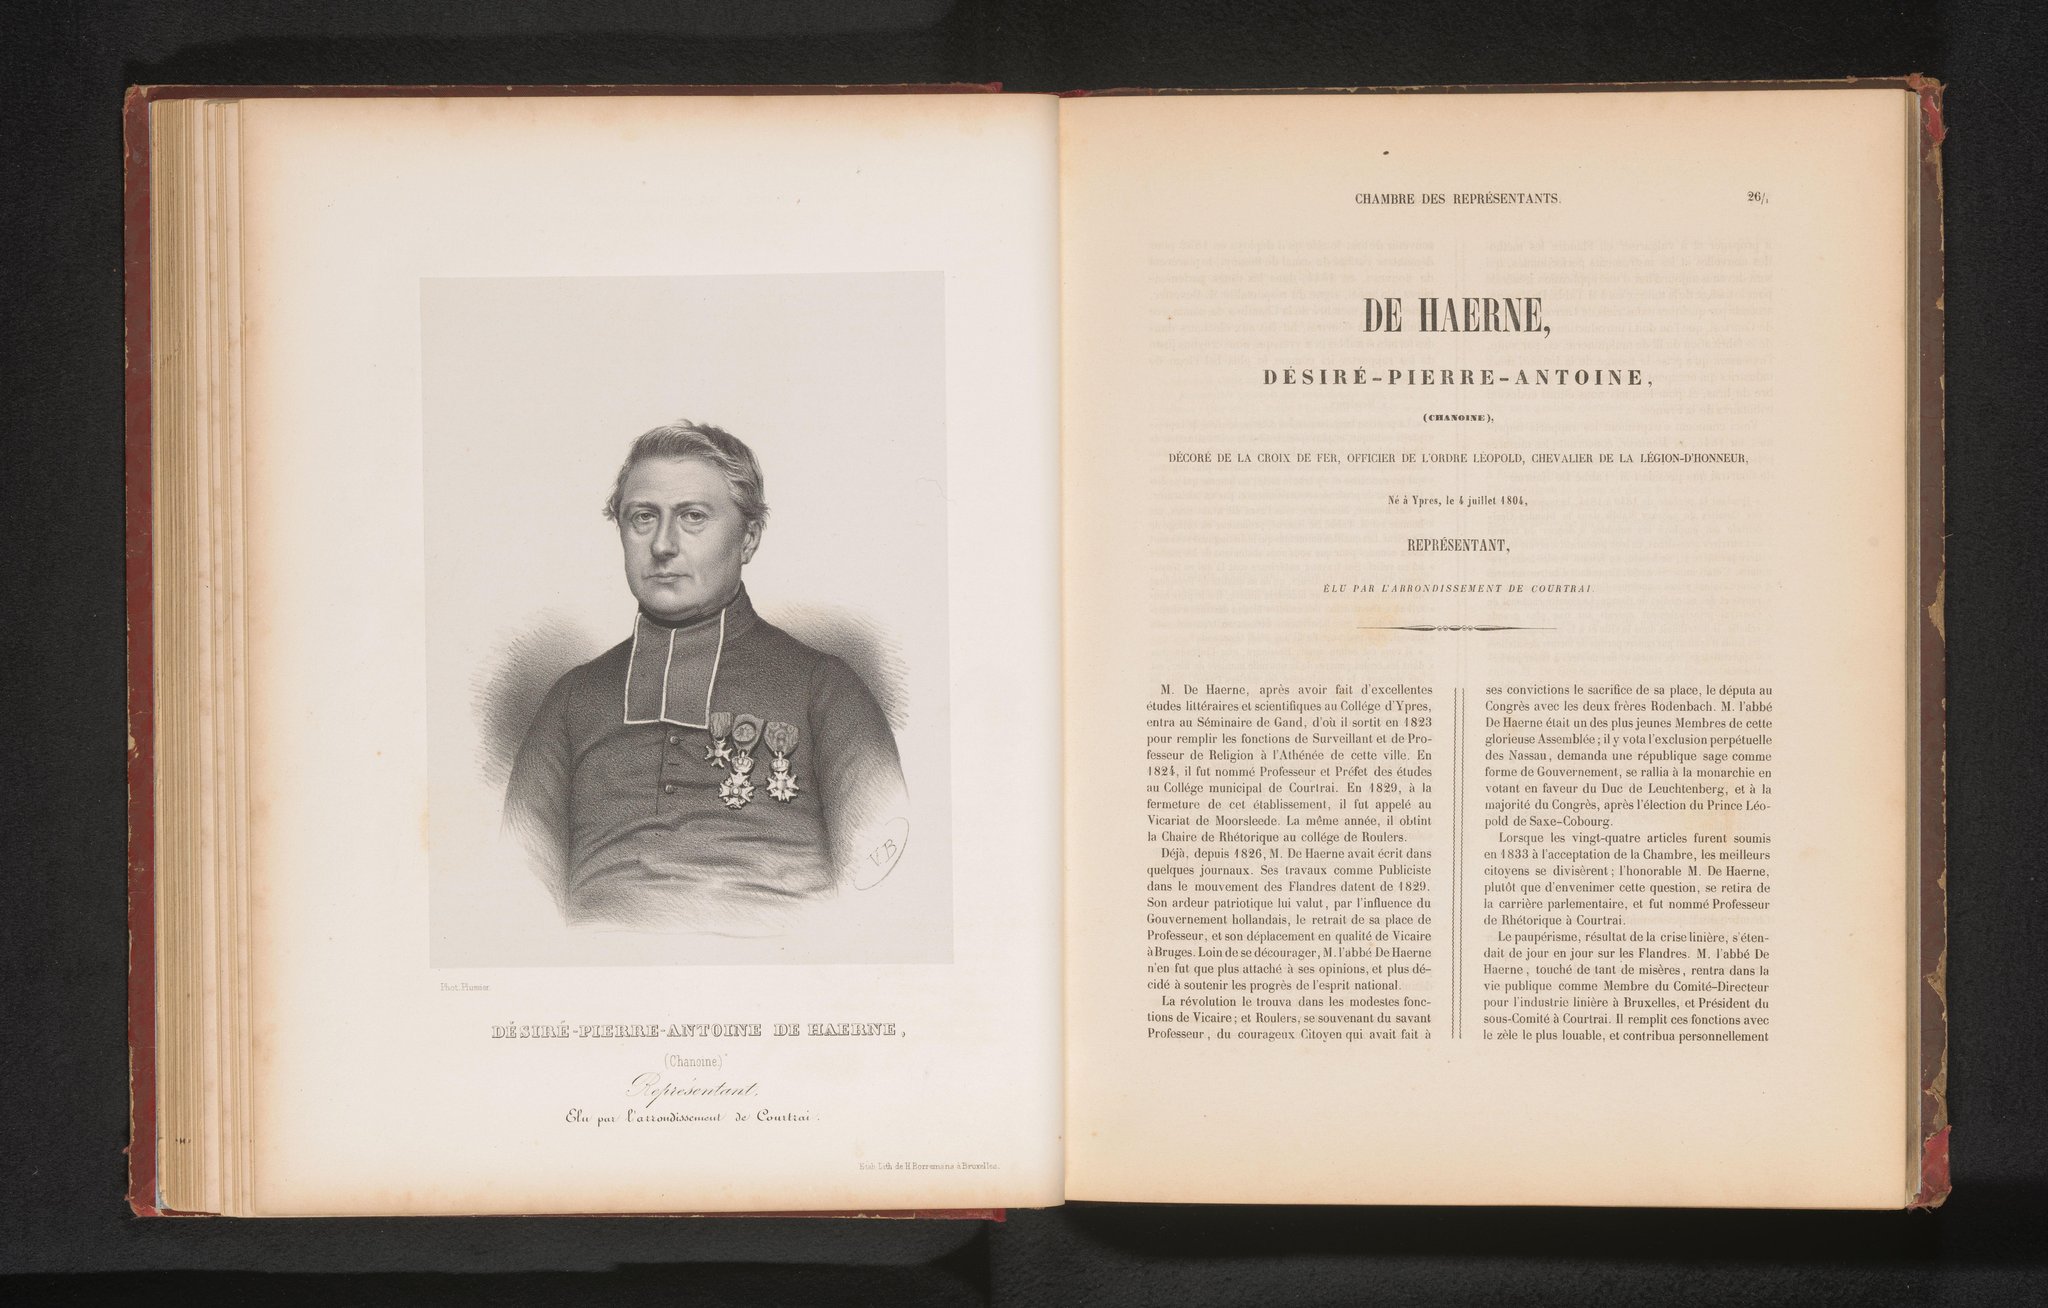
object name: print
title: Reproductie van een foto van een portret van Désiré de Haerne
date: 1853-1858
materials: paper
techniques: lithograph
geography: brussels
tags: politician, historical persons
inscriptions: inscription: ‘Représentant,/ Elu par l'arrondissement de Courtrai.’